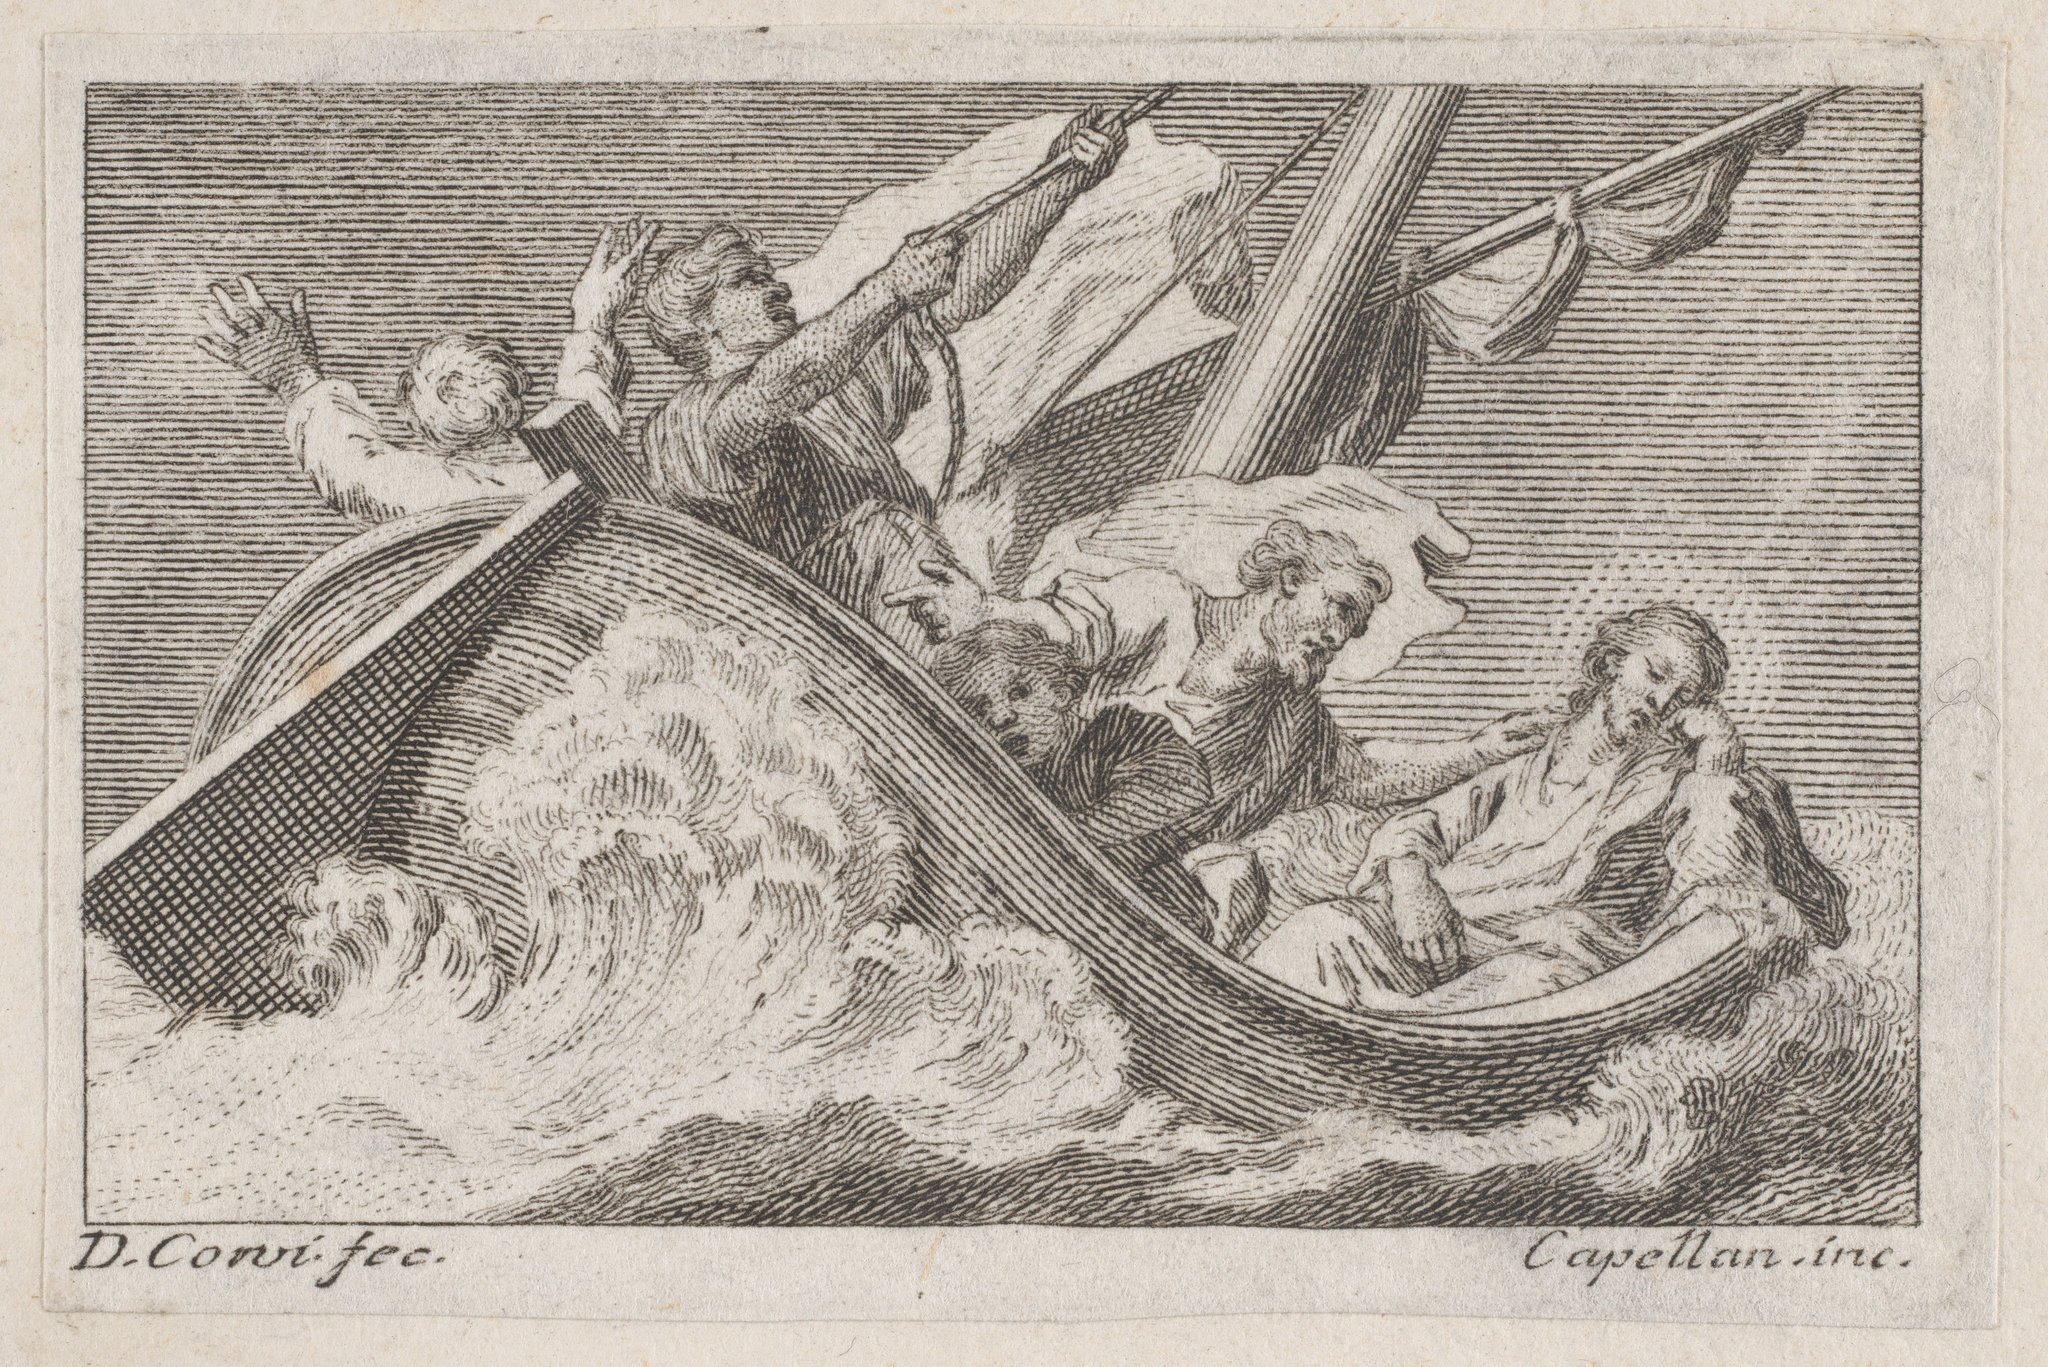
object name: print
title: Christ on a boat with fishermen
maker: antonio capellan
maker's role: artist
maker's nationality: italian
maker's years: 1740-1793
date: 1760-1793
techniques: etching